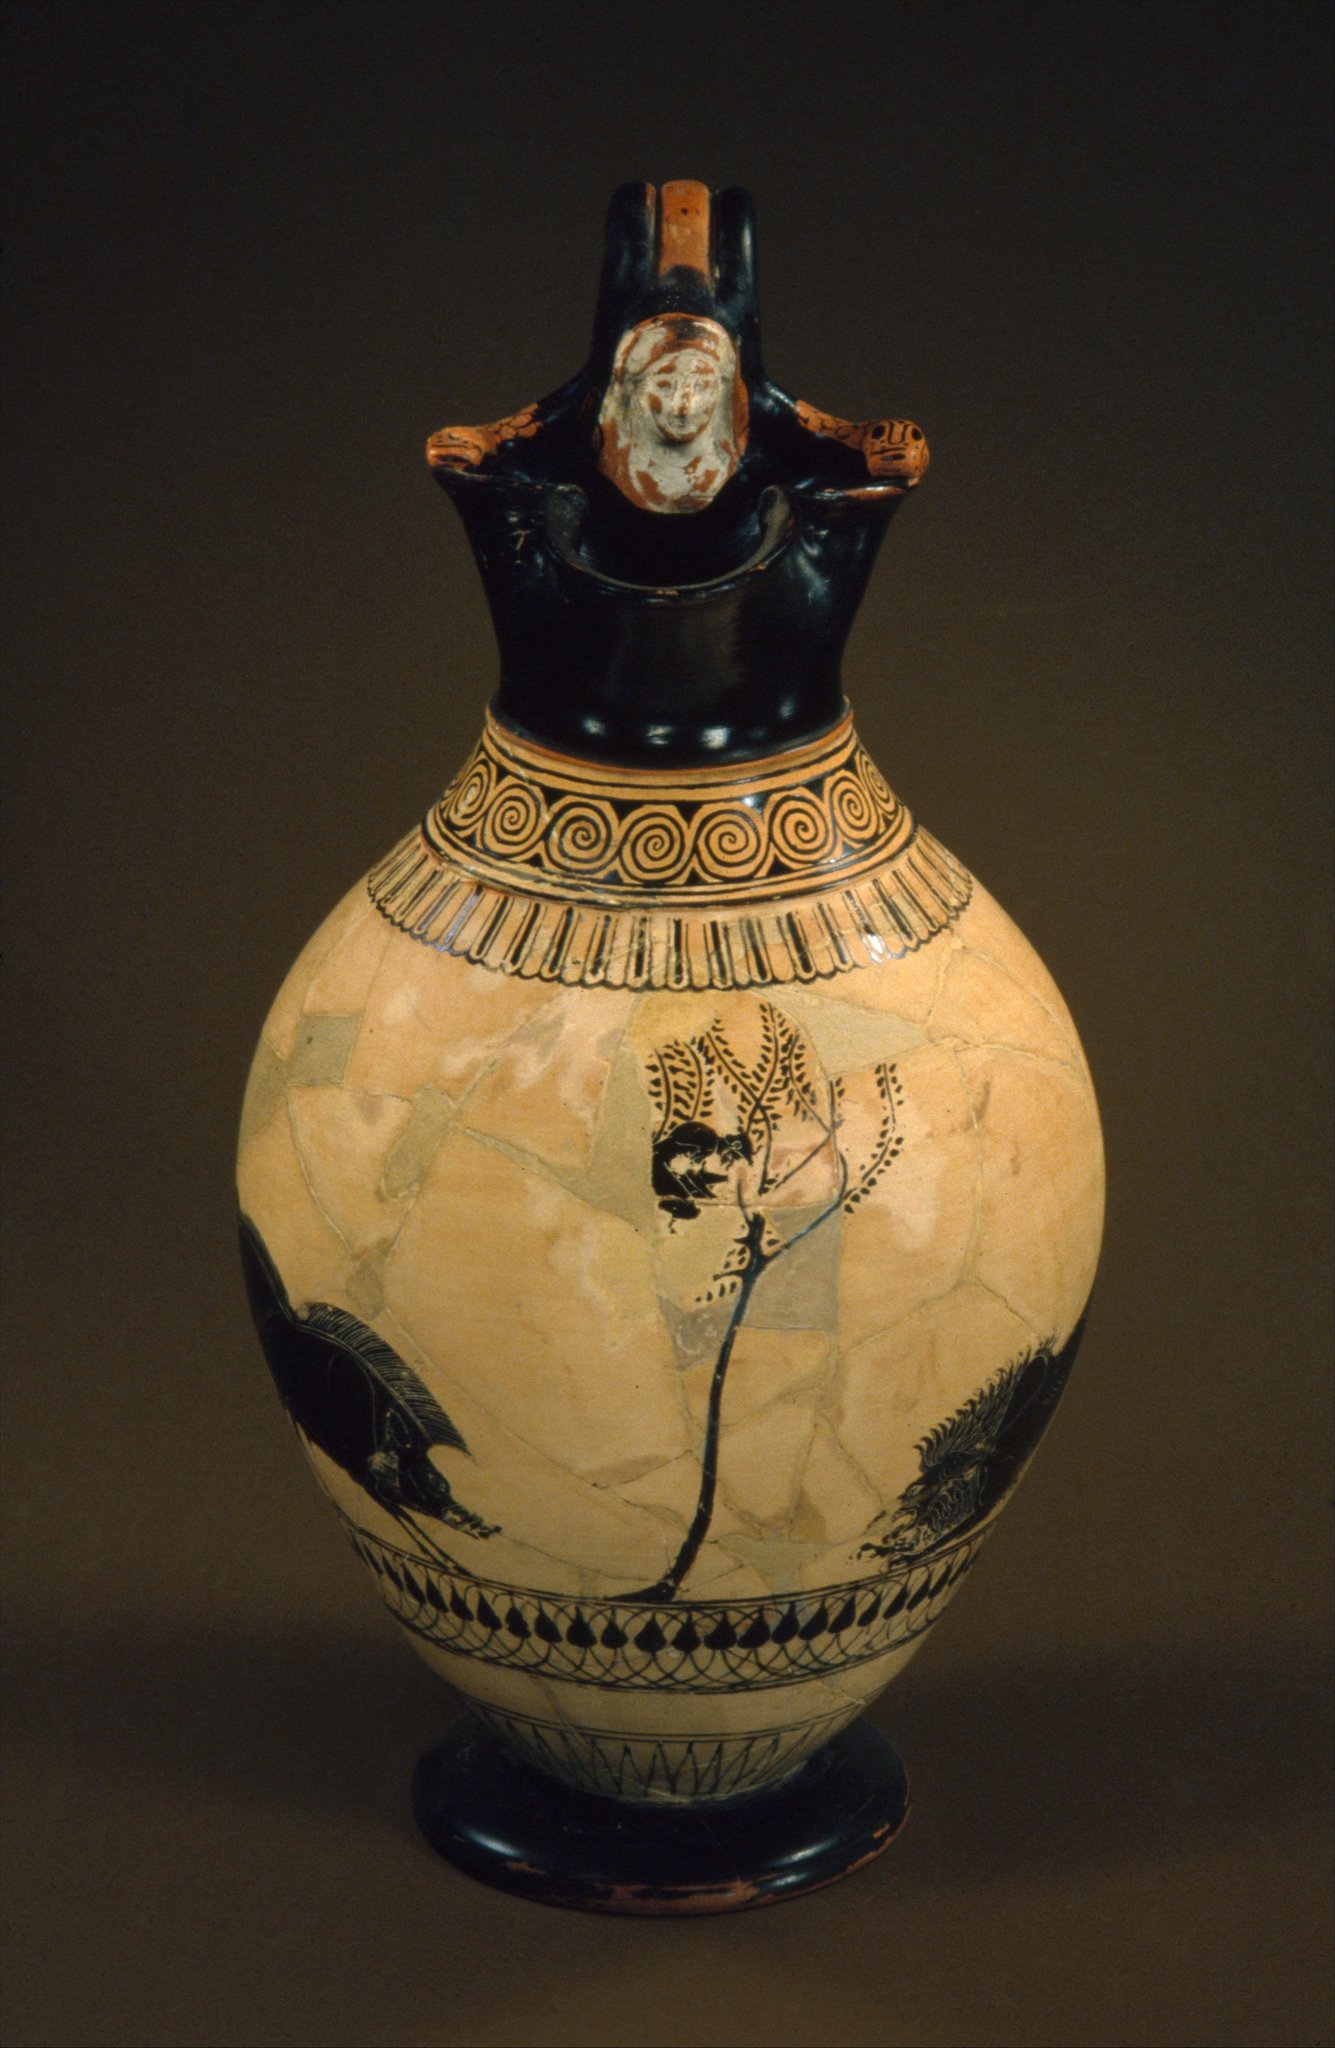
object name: oinochoe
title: Terracotta oinochoe (jug)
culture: greek, attic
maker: painter of london b 620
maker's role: artist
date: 520 BCE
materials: terracotta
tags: boars,lions